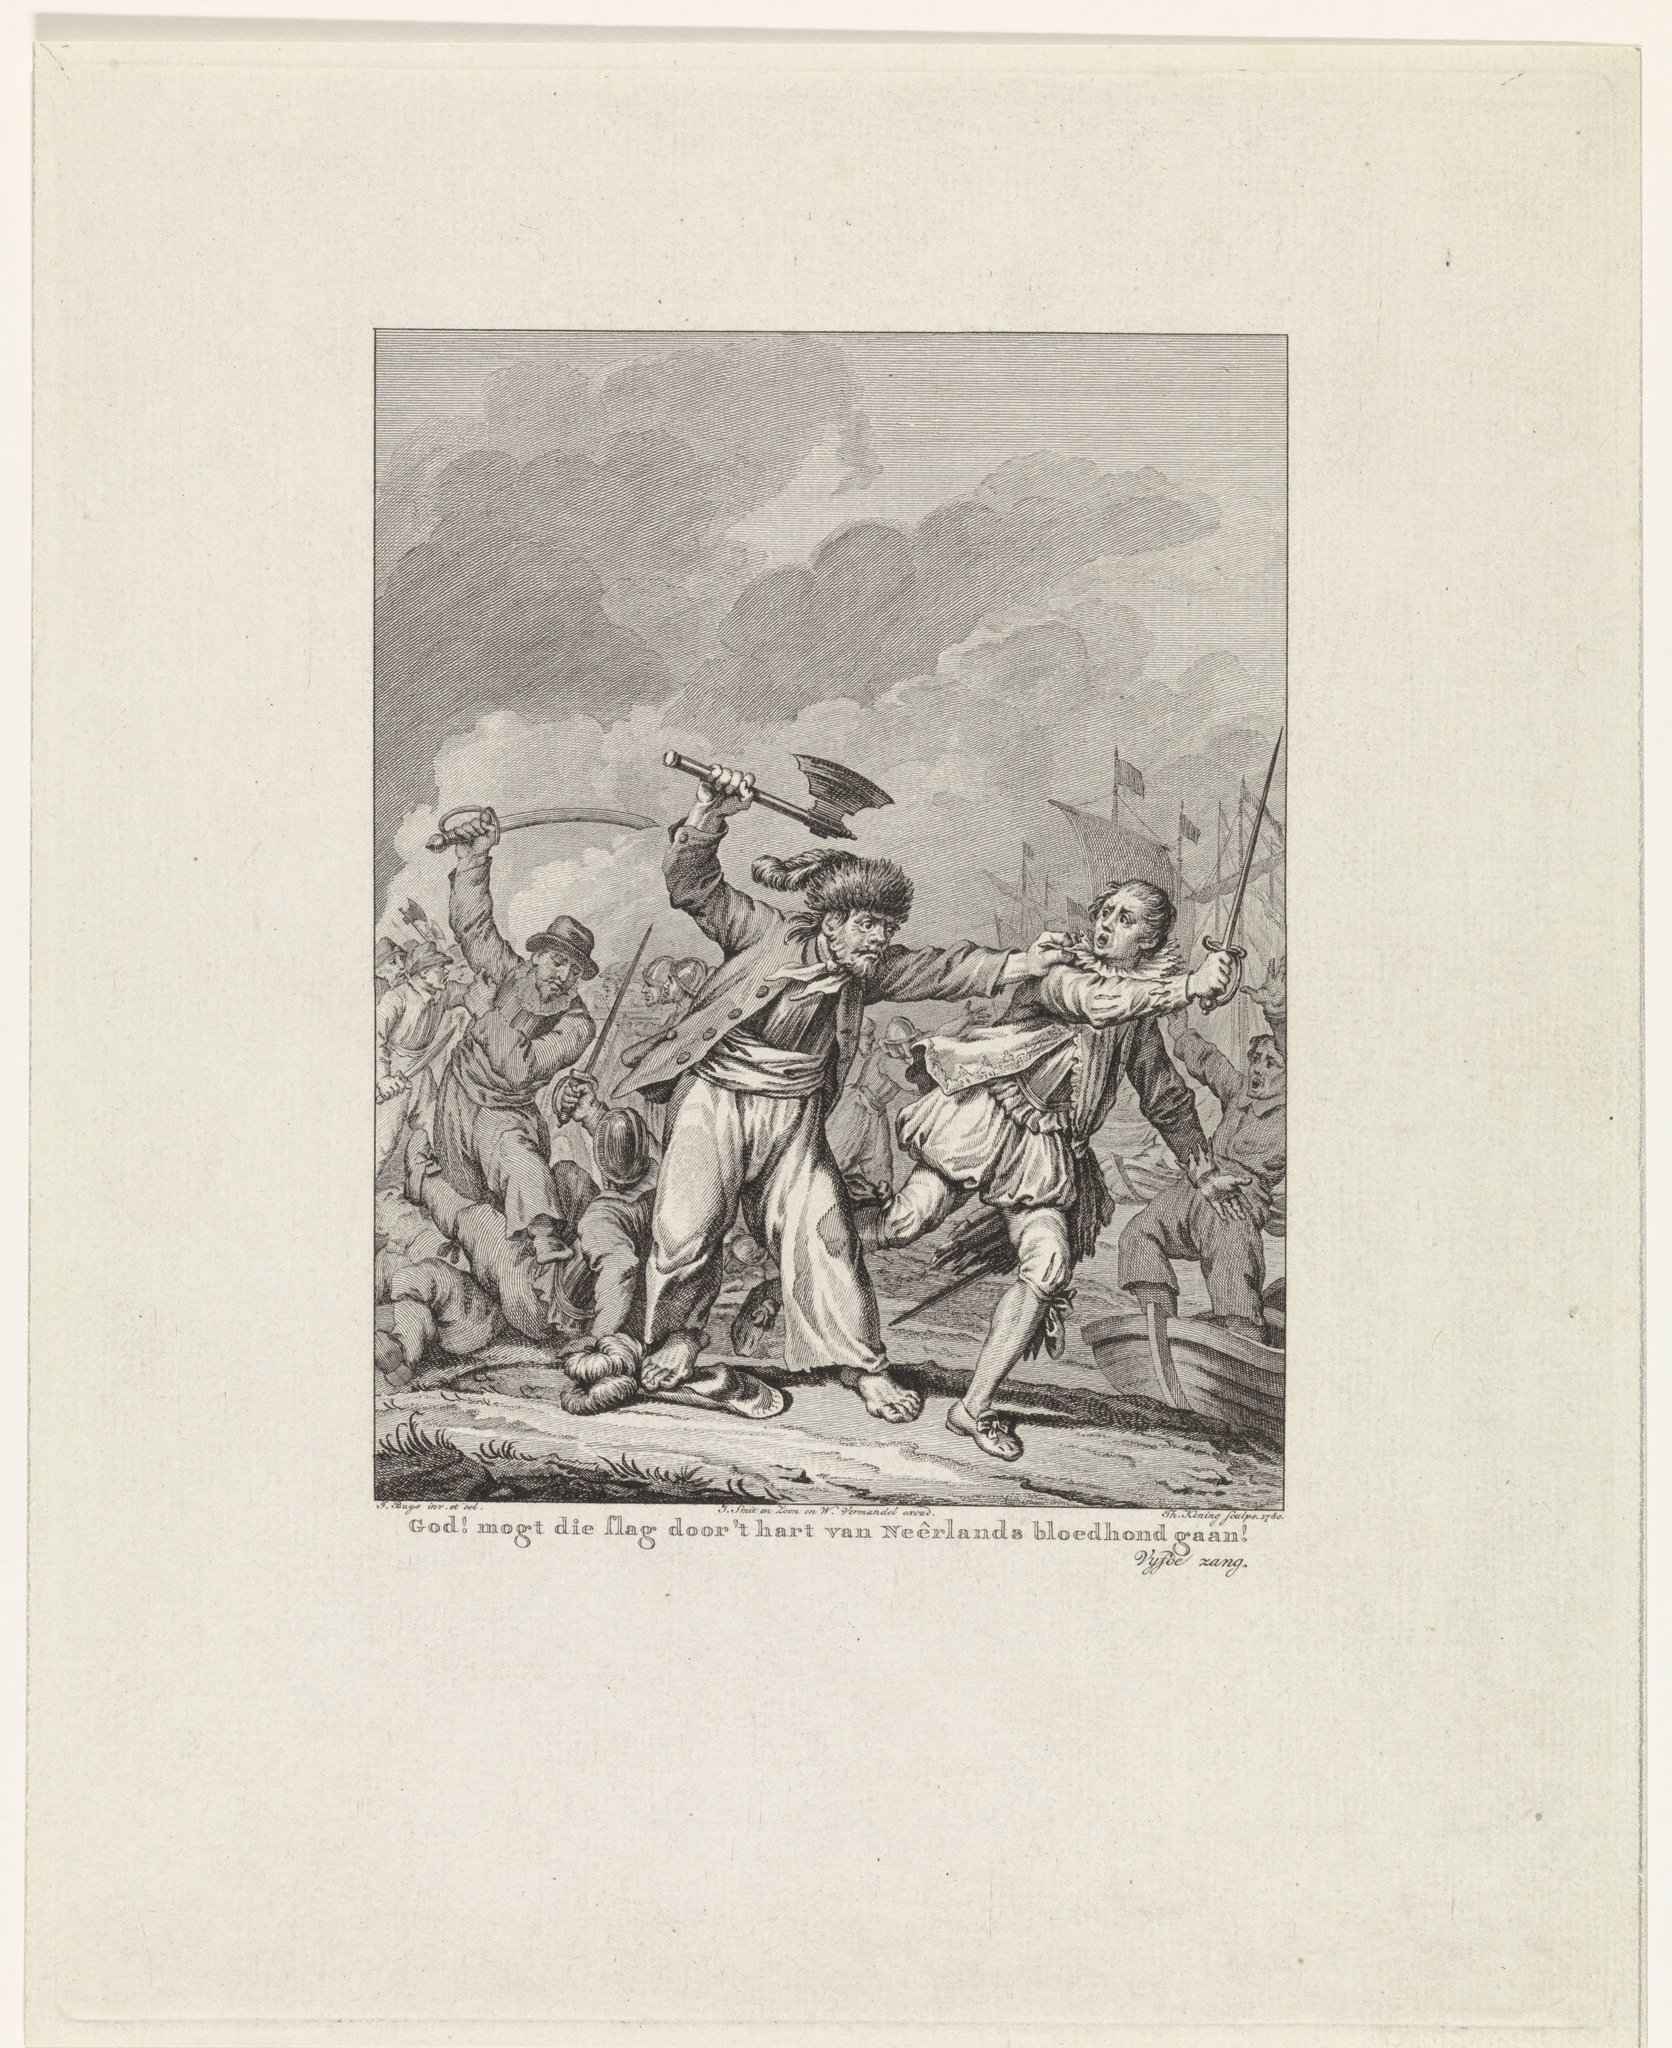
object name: history print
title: Taferelen uit het leven van prins Willem I, 1568-1584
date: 1880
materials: paper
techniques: engraving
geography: amsterdam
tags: flushing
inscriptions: collector's mark: Lugt 2228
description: Gevecht tussen de met een bijl bewapende watergeus Barthold Entes en de Spanjaard Agulo te Vlissingen, 1572. Deze prent maakt deel uit van een serie van 24 prenten met taferelen uit het leven van prins Willem I, 1568-1584 en is een illustratie bij de vijfde zang.